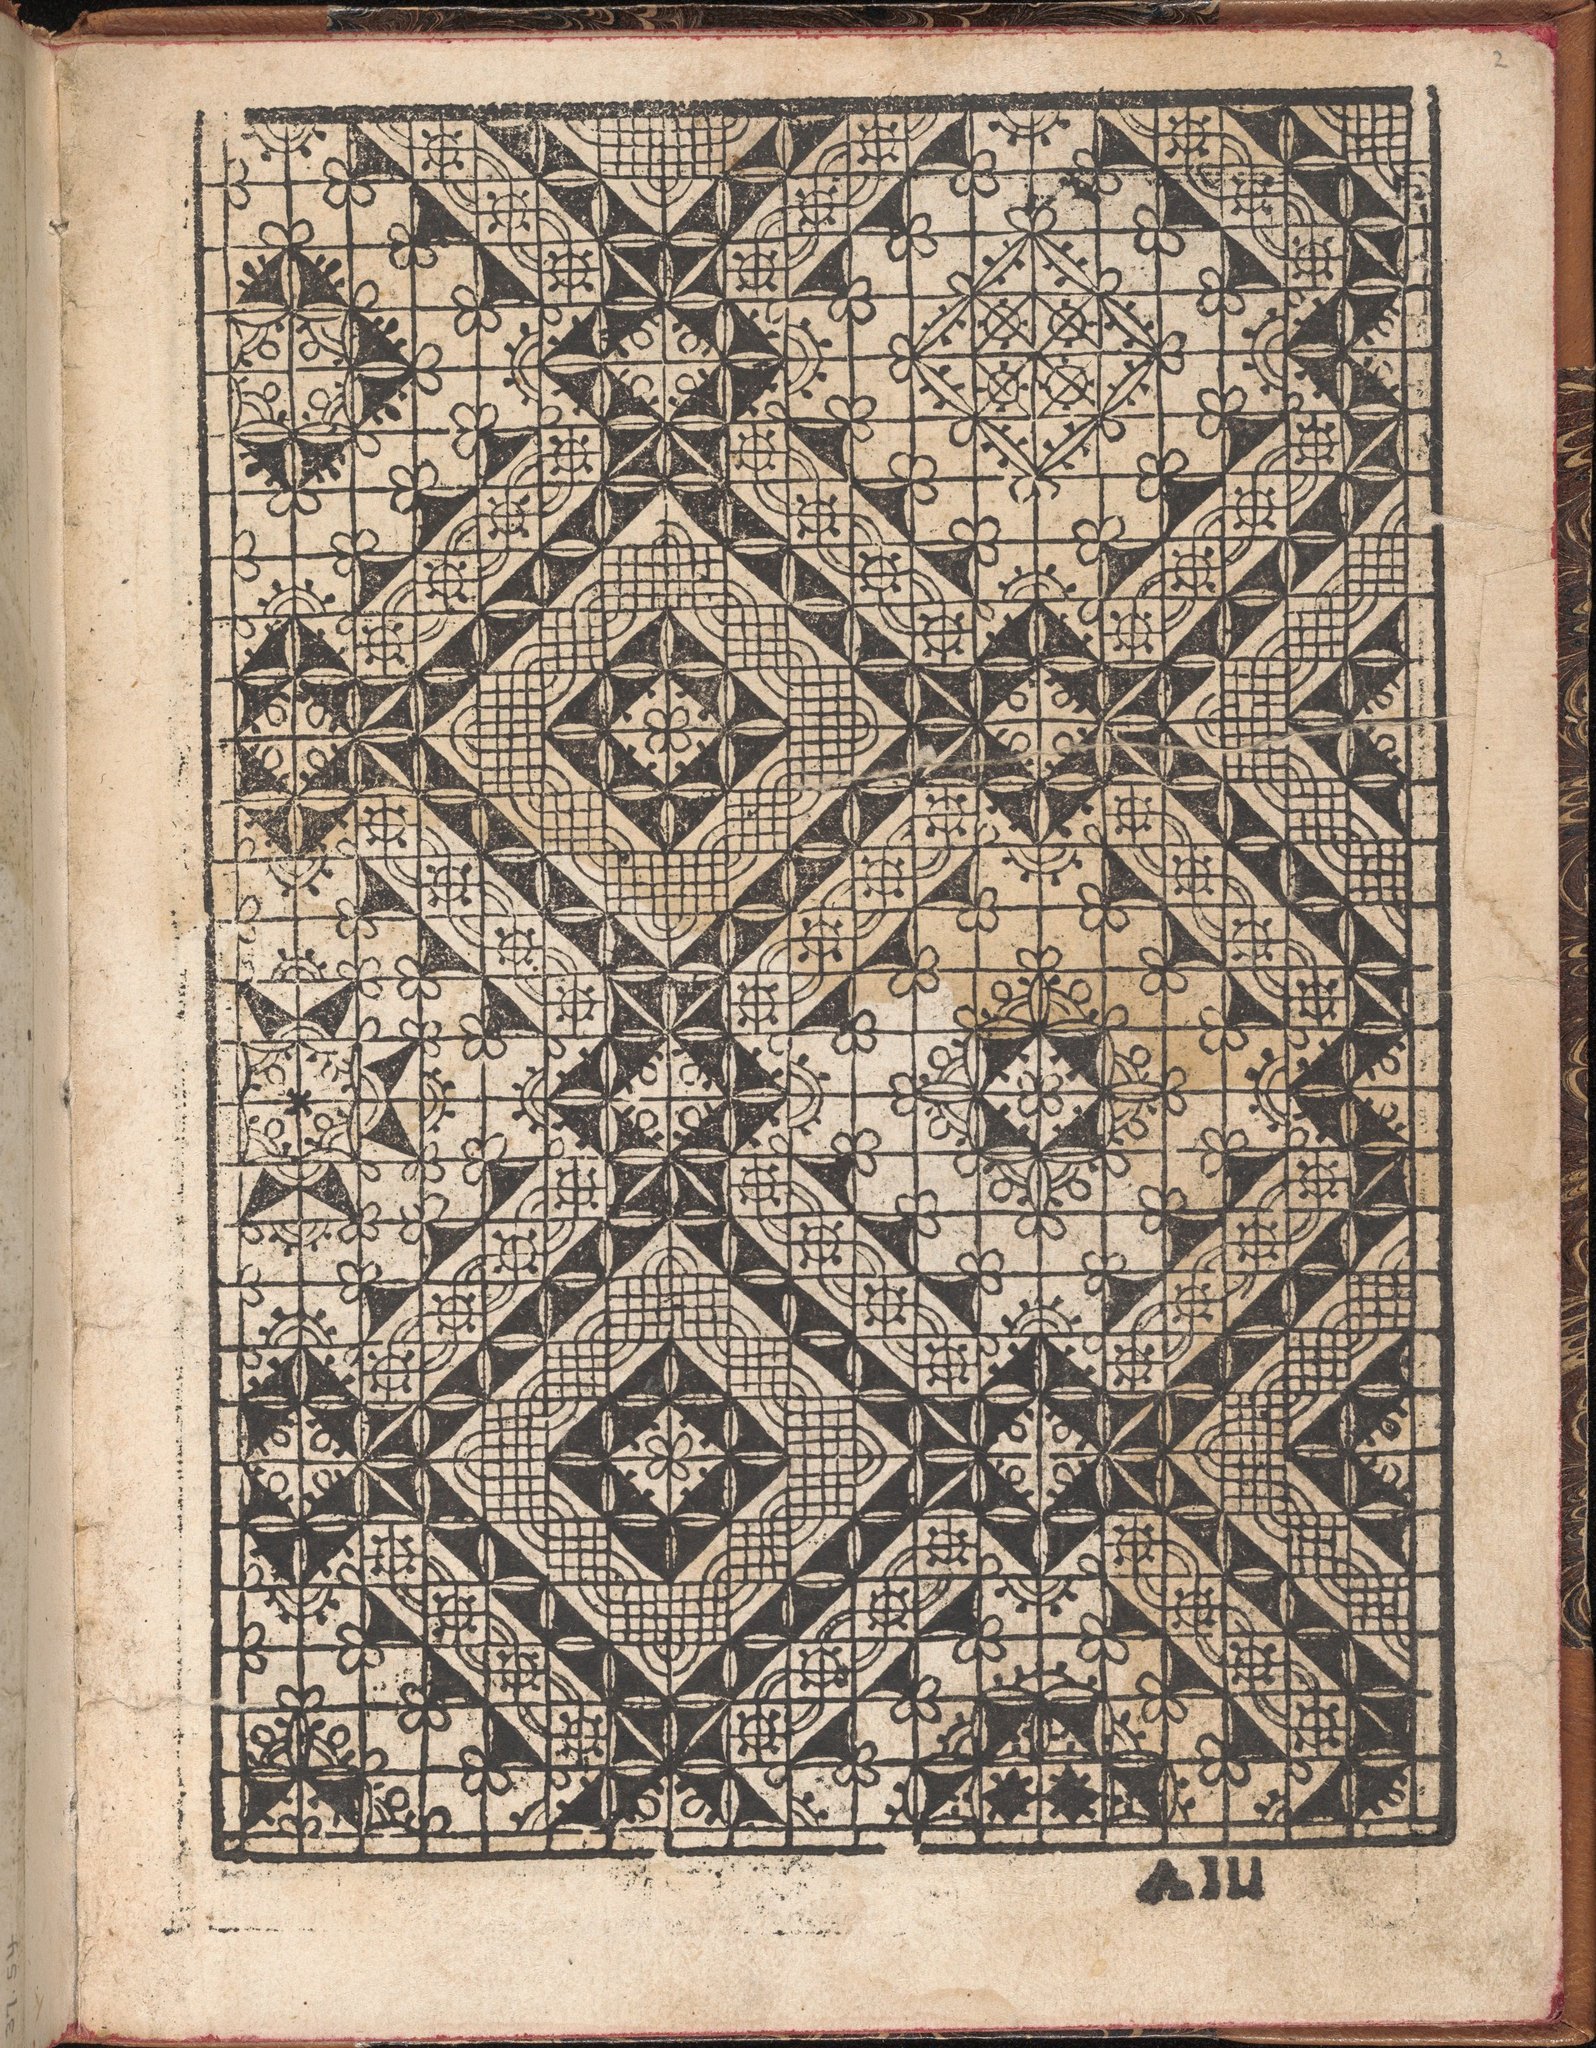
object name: book print ornament architecture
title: Spechio di pensieri delle belle et Virtudiose donne, page 2 (recto)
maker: matteo pagano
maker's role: publisher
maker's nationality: italian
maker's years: 1515-1588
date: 1546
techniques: woodcut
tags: ornament